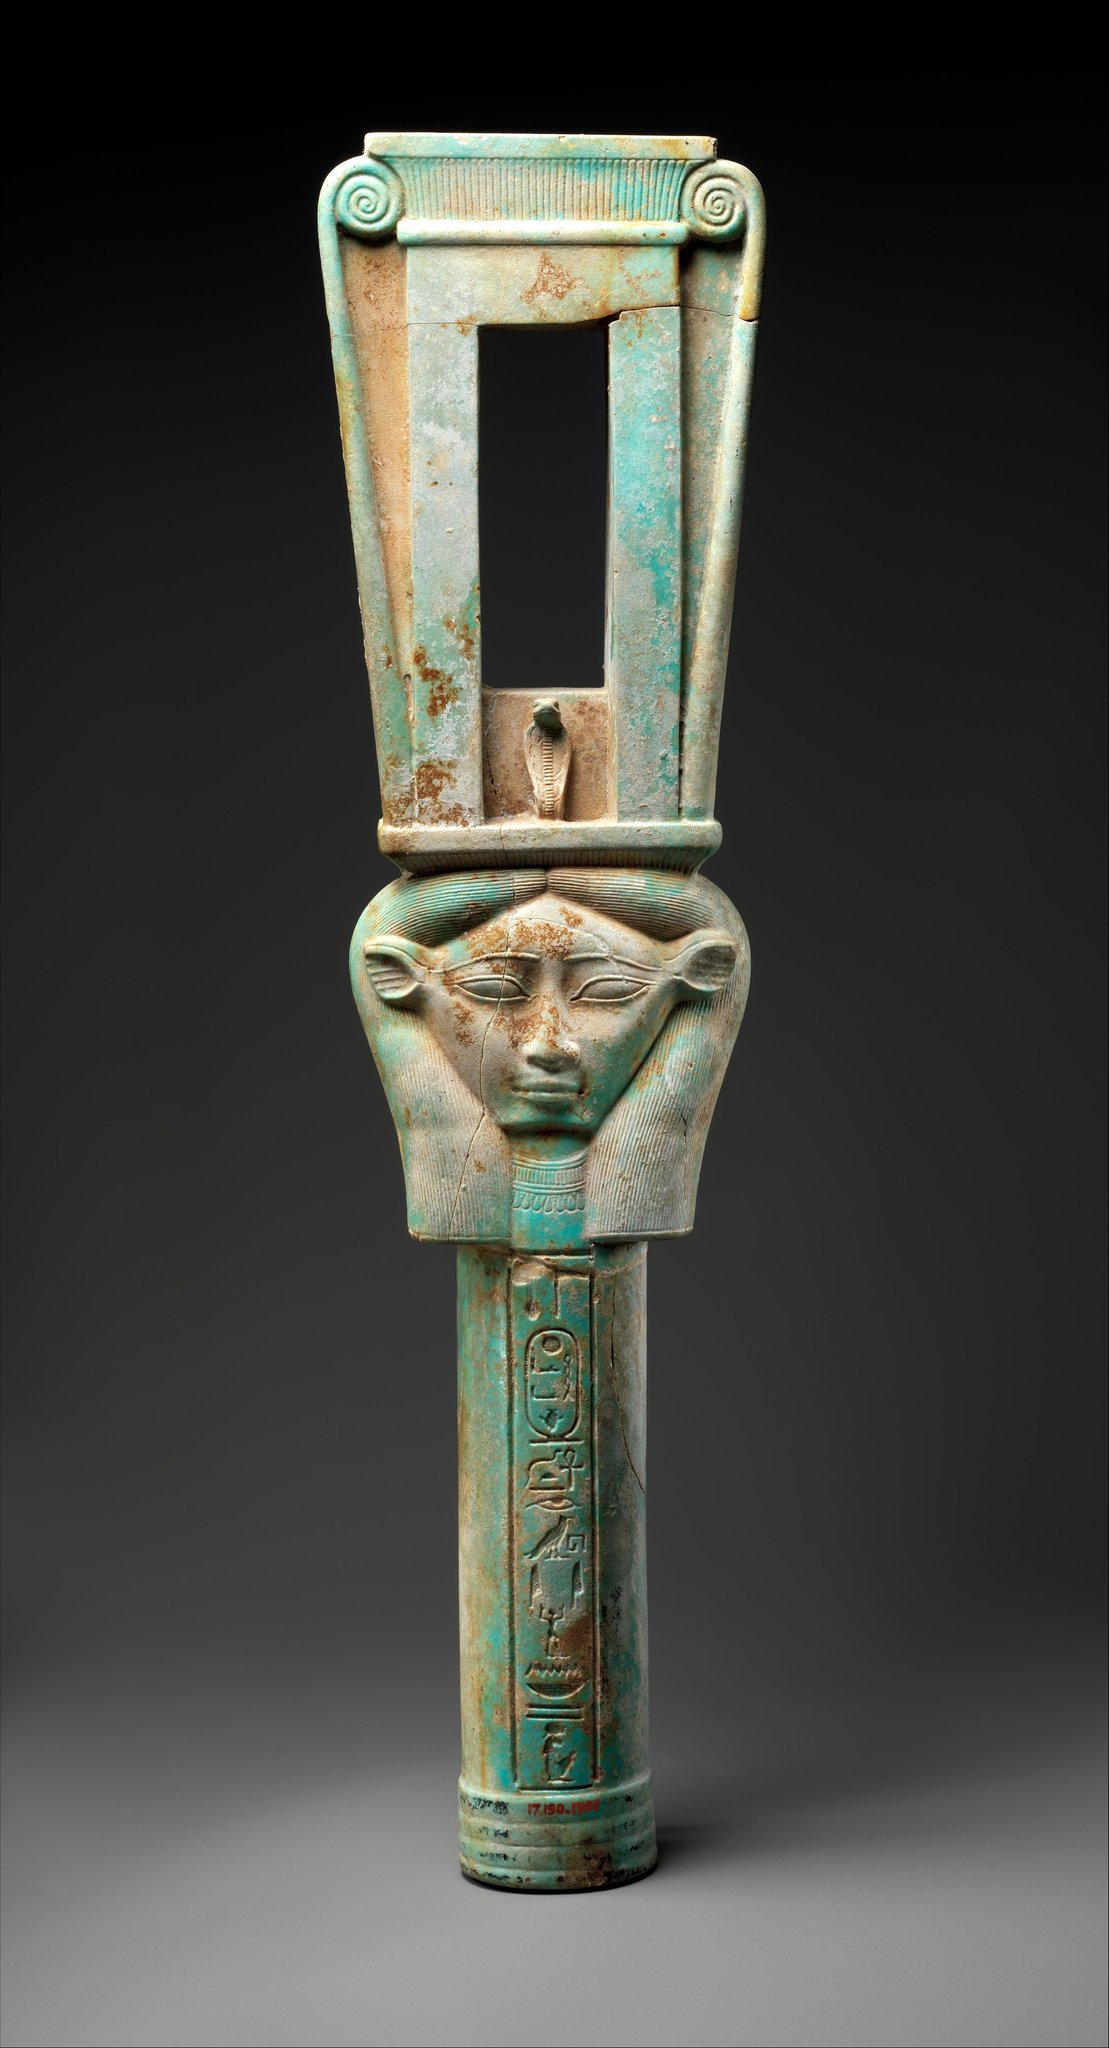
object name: music, sistrum, hathor emblem, bat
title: Shrine sistrum of King Apries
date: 589-570 BCE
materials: faience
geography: egypt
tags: musical instruments,women,hieroglyphs